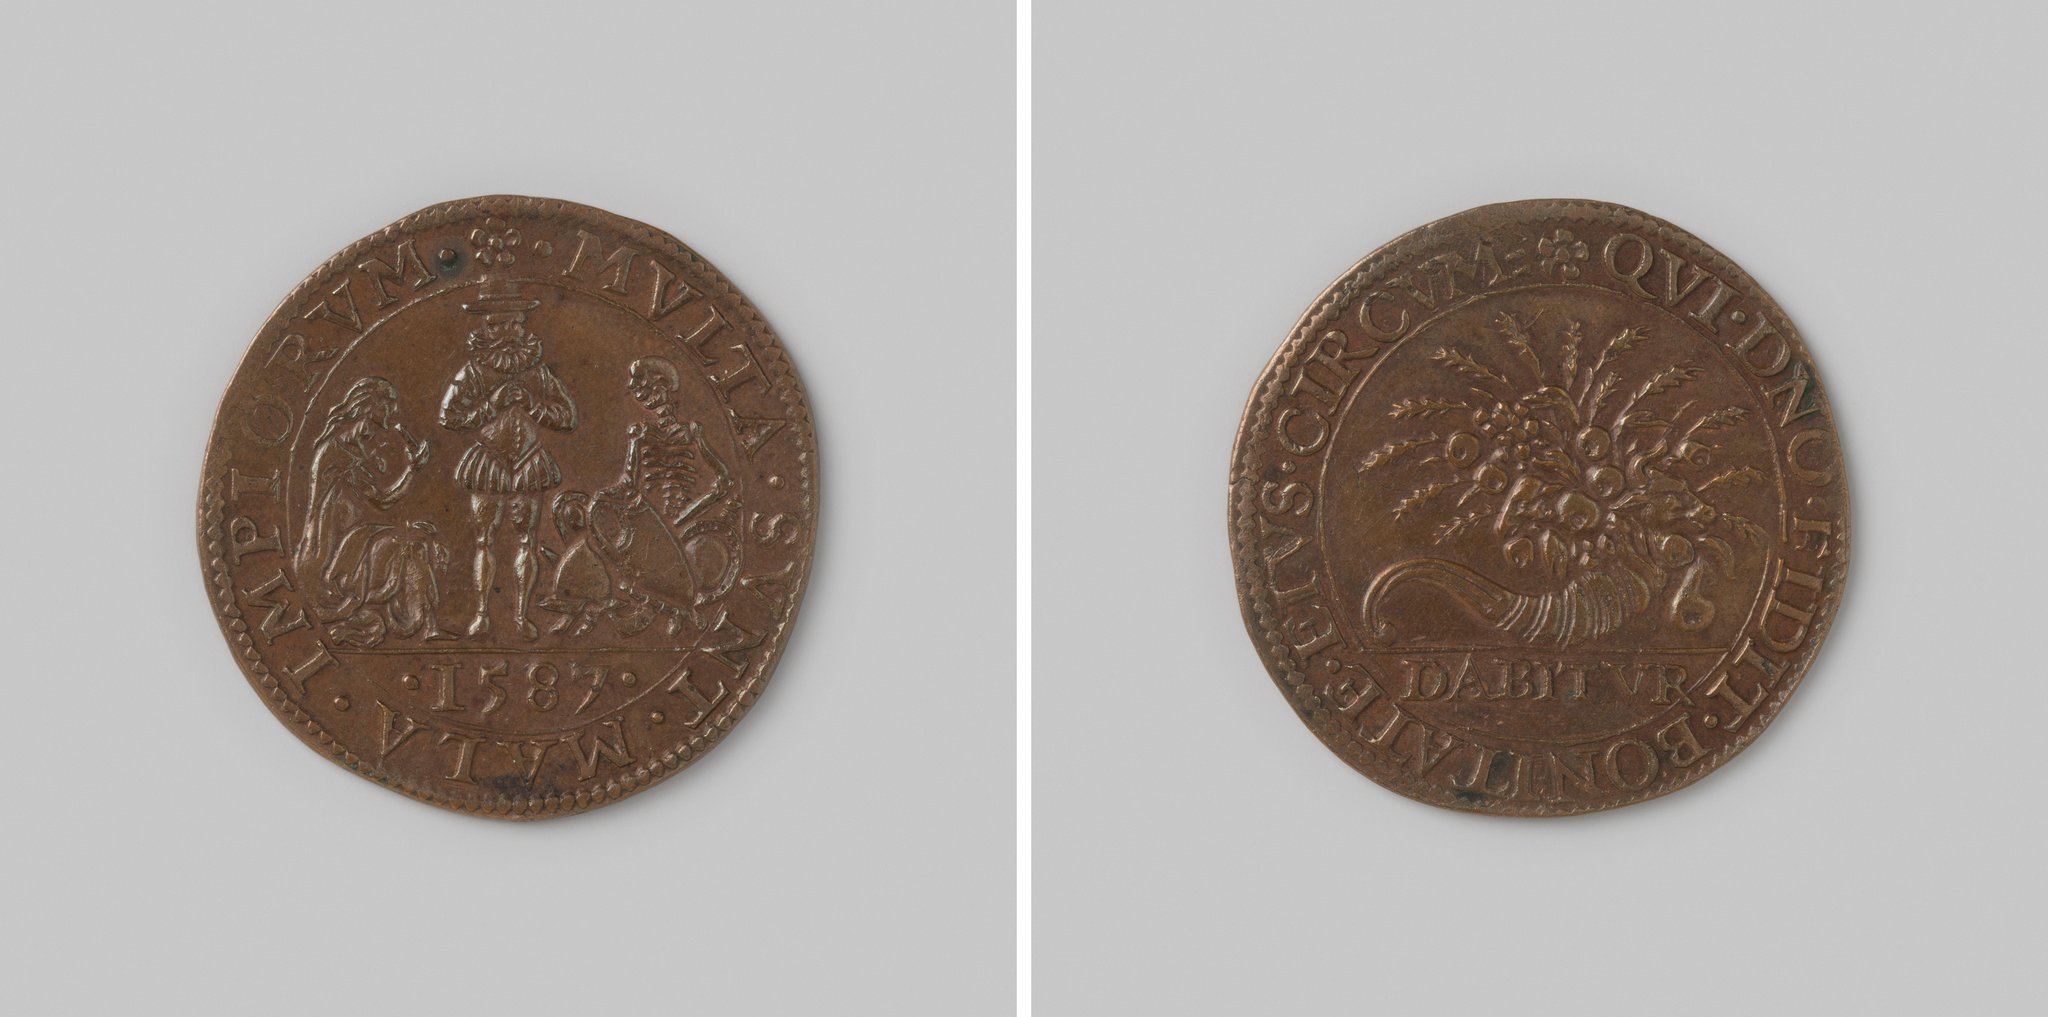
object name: history medal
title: Rekenpenning uit Dordrecht op de hongersnood in Artois 1587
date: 1587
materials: copper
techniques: striking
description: Koperen penning, op de voorzijde een man tussen de Honger en de Dood, met afsnedetekst en omschrift, op de keerzijde een hoorn des overvloeds, met afsnedetekst en omschrift.